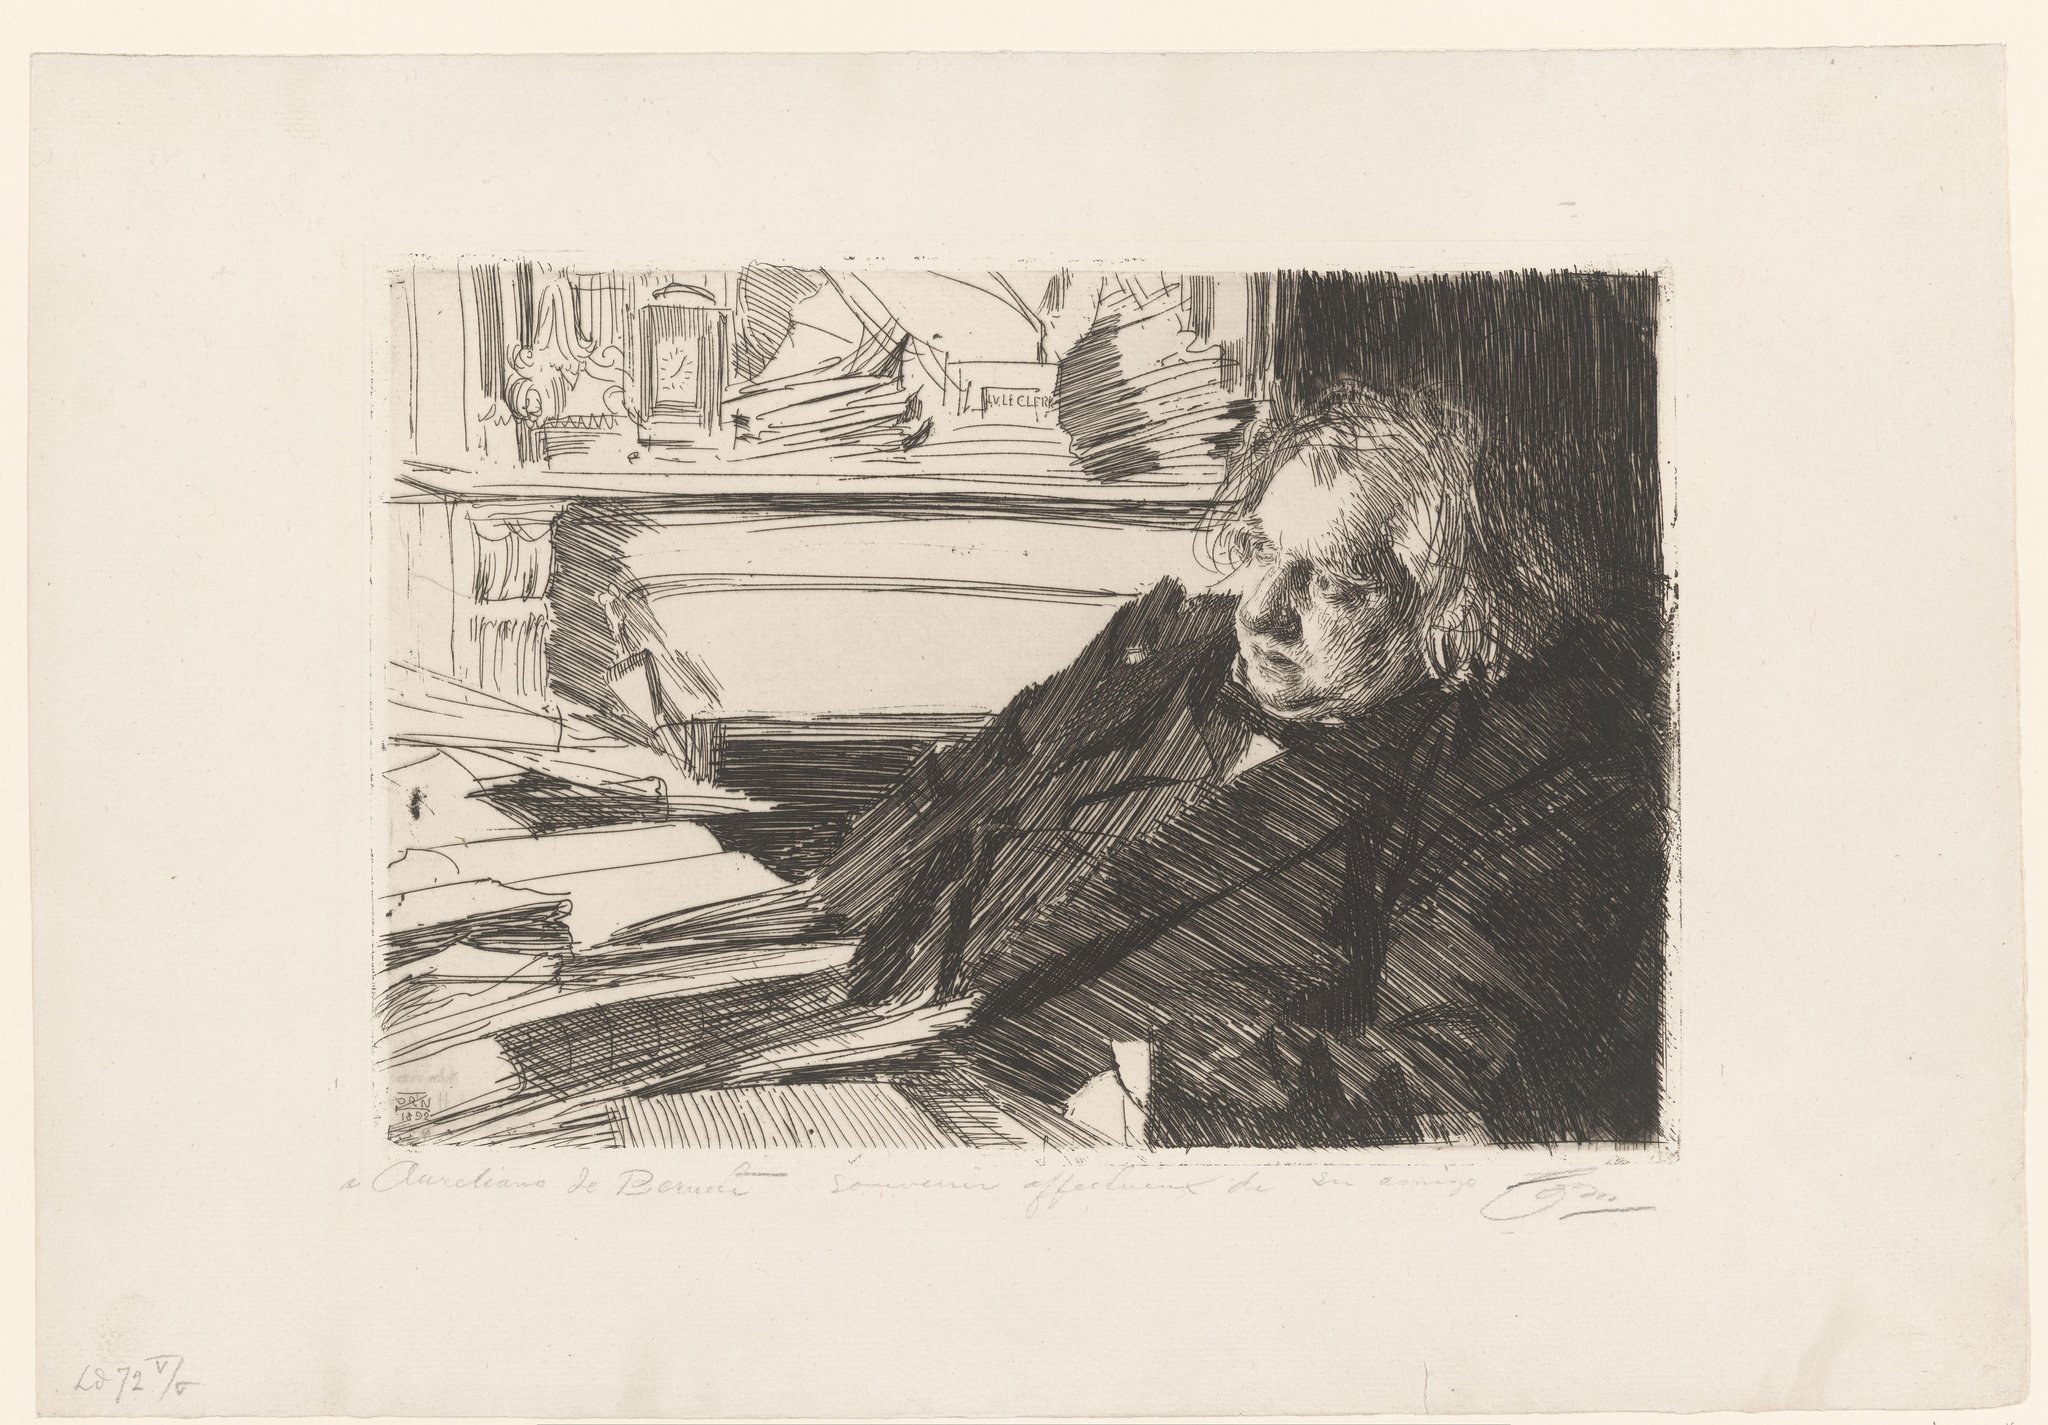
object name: print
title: Portret van Ernest Renan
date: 1892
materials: paper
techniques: etching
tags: historical persons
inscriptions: inscription: ‘a Aurelio de Baruch souvenir affectueux de san amigo Zorn’, collector's mark: Lugt 2228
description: Portret van Ernest Renan, Frans filosoof en schrijver.